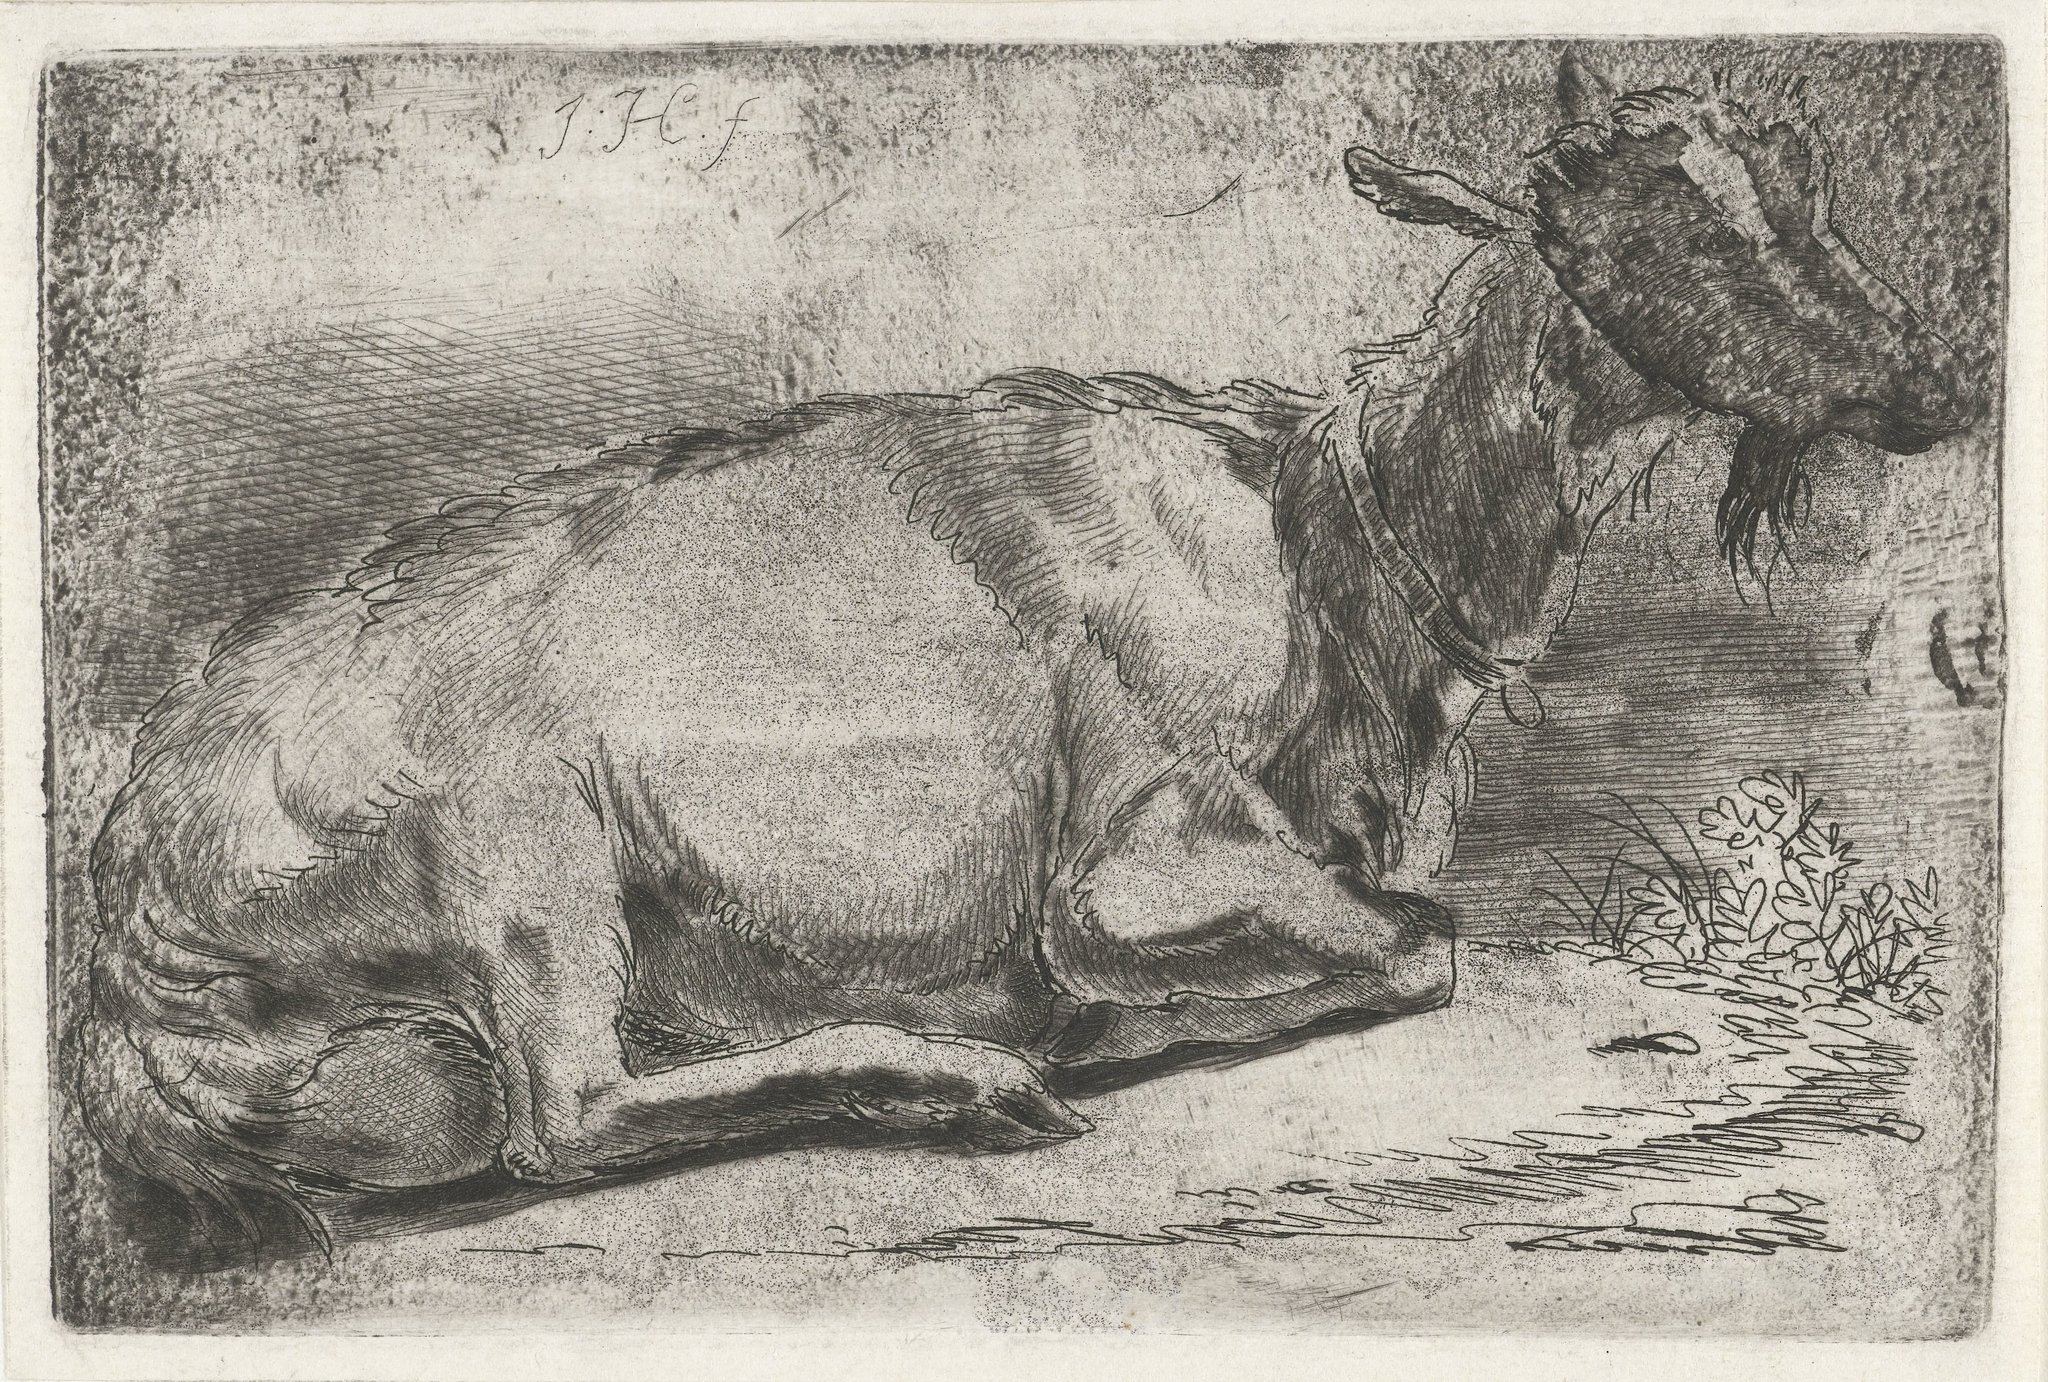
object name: print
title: Liggende geit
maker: jabes heenck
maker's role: draughtsman, print maker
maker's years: 1752-1782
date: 1767-1782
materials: paper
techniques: aquatint, drypoint, etching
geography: northern netherlands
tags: goat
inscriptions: collector's mark: Lugt 2228